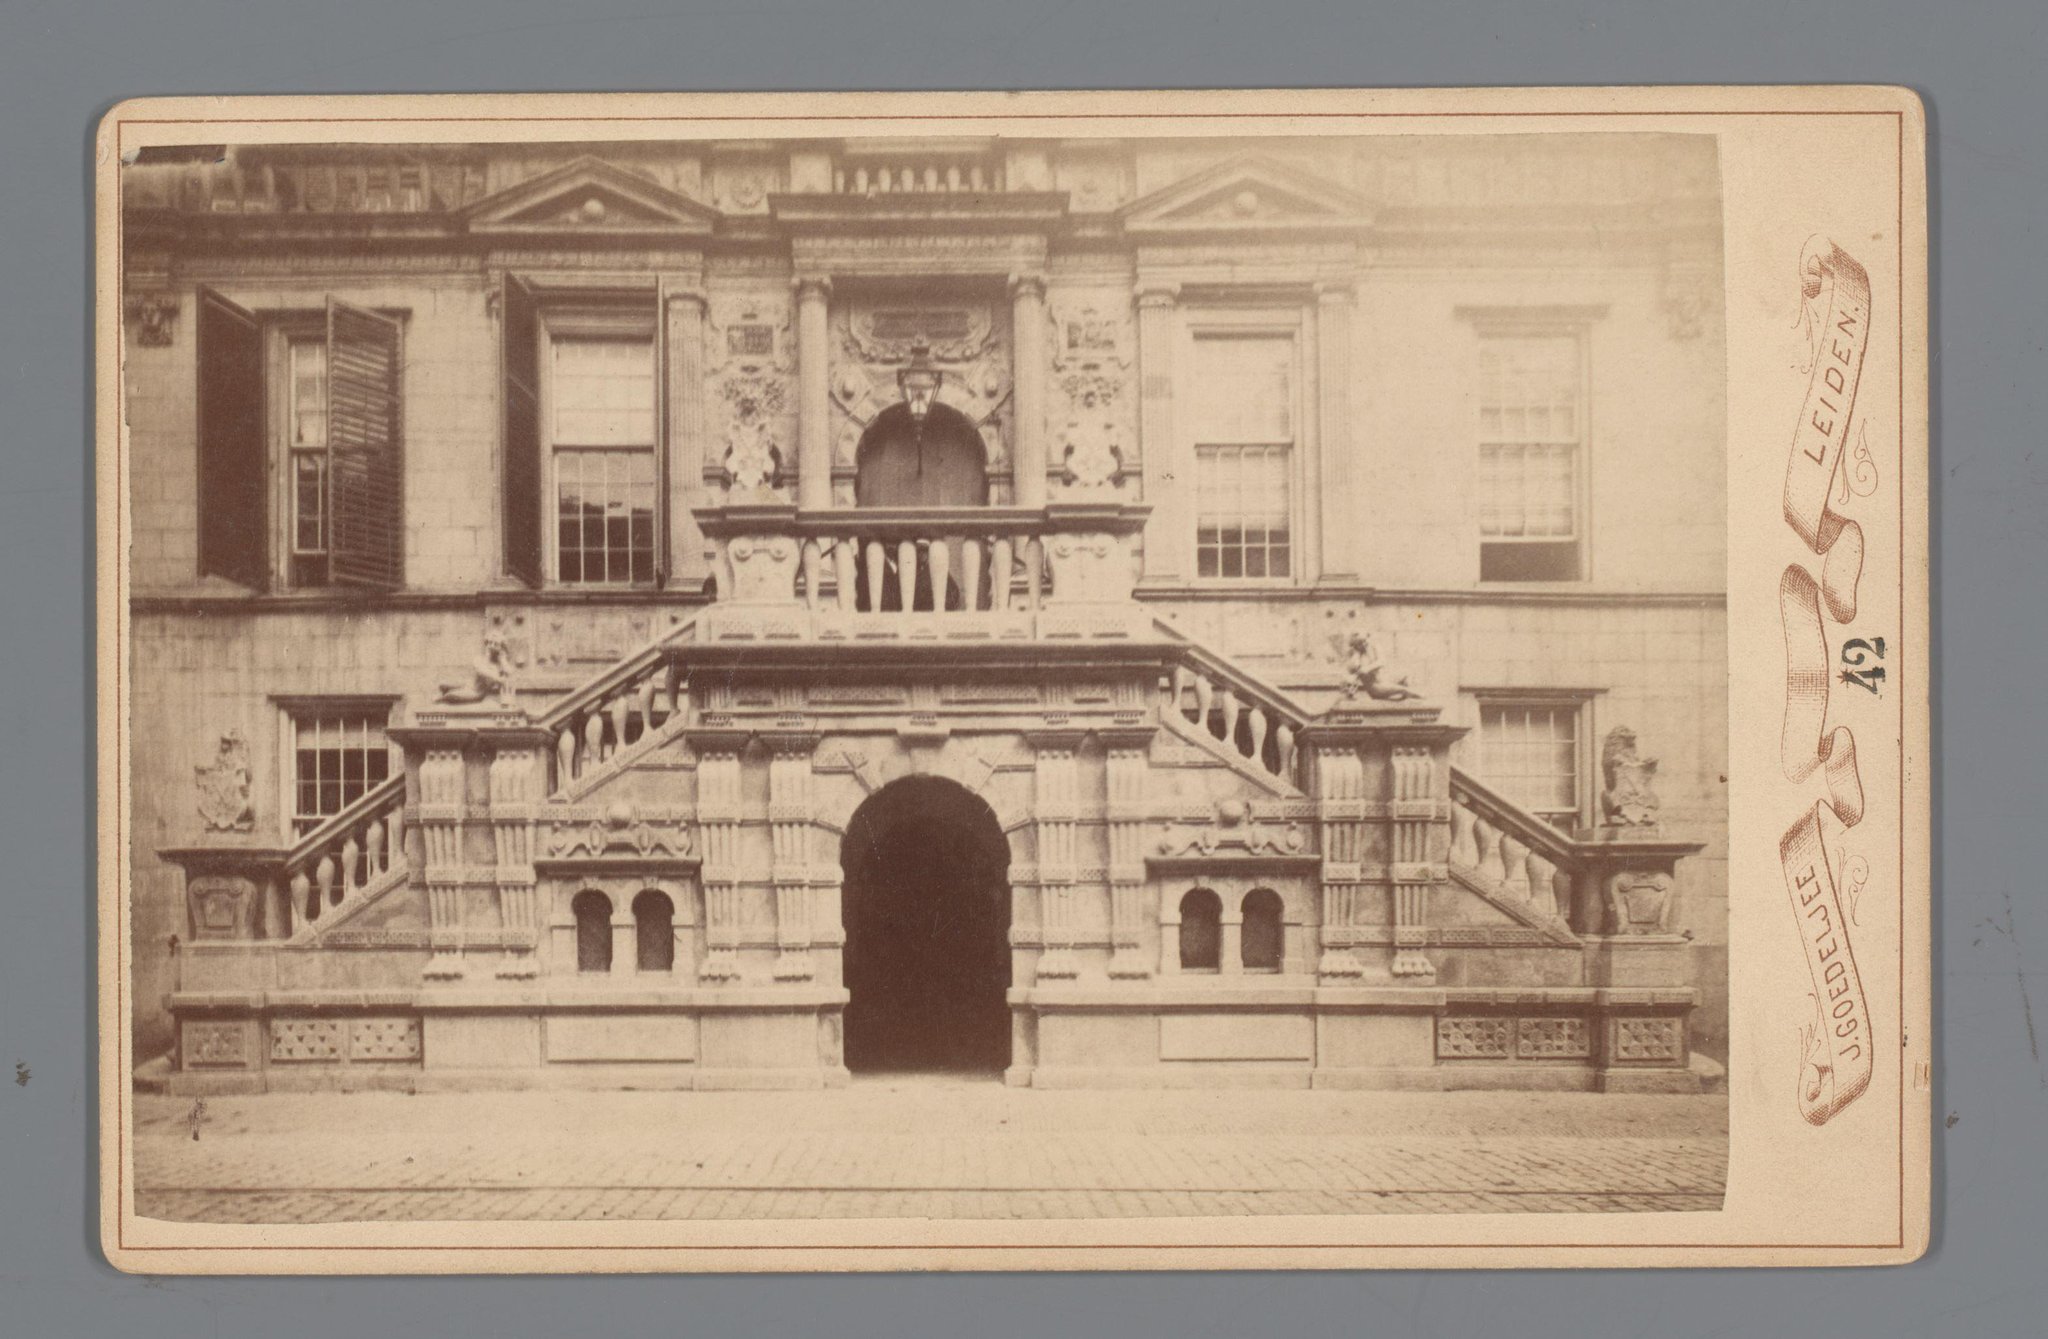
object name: cabinet photograph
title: Ingang van het stadhuis te Leiden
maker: jan goedeljee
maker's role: fotograaf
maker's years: 1824-1905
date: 1879-1900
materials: cardboard, photographic support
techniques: albumen print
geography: leiden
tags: townhall, leiden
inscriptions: inscription: ‘J. Goedeljee/ Leiden/ 42’, annotation: ‘Het stadhuis/ Leiden’, inscription: ‘J. Goedeljee (...) Leiden/ Hoogewoerd 160/ naby de Plantage’